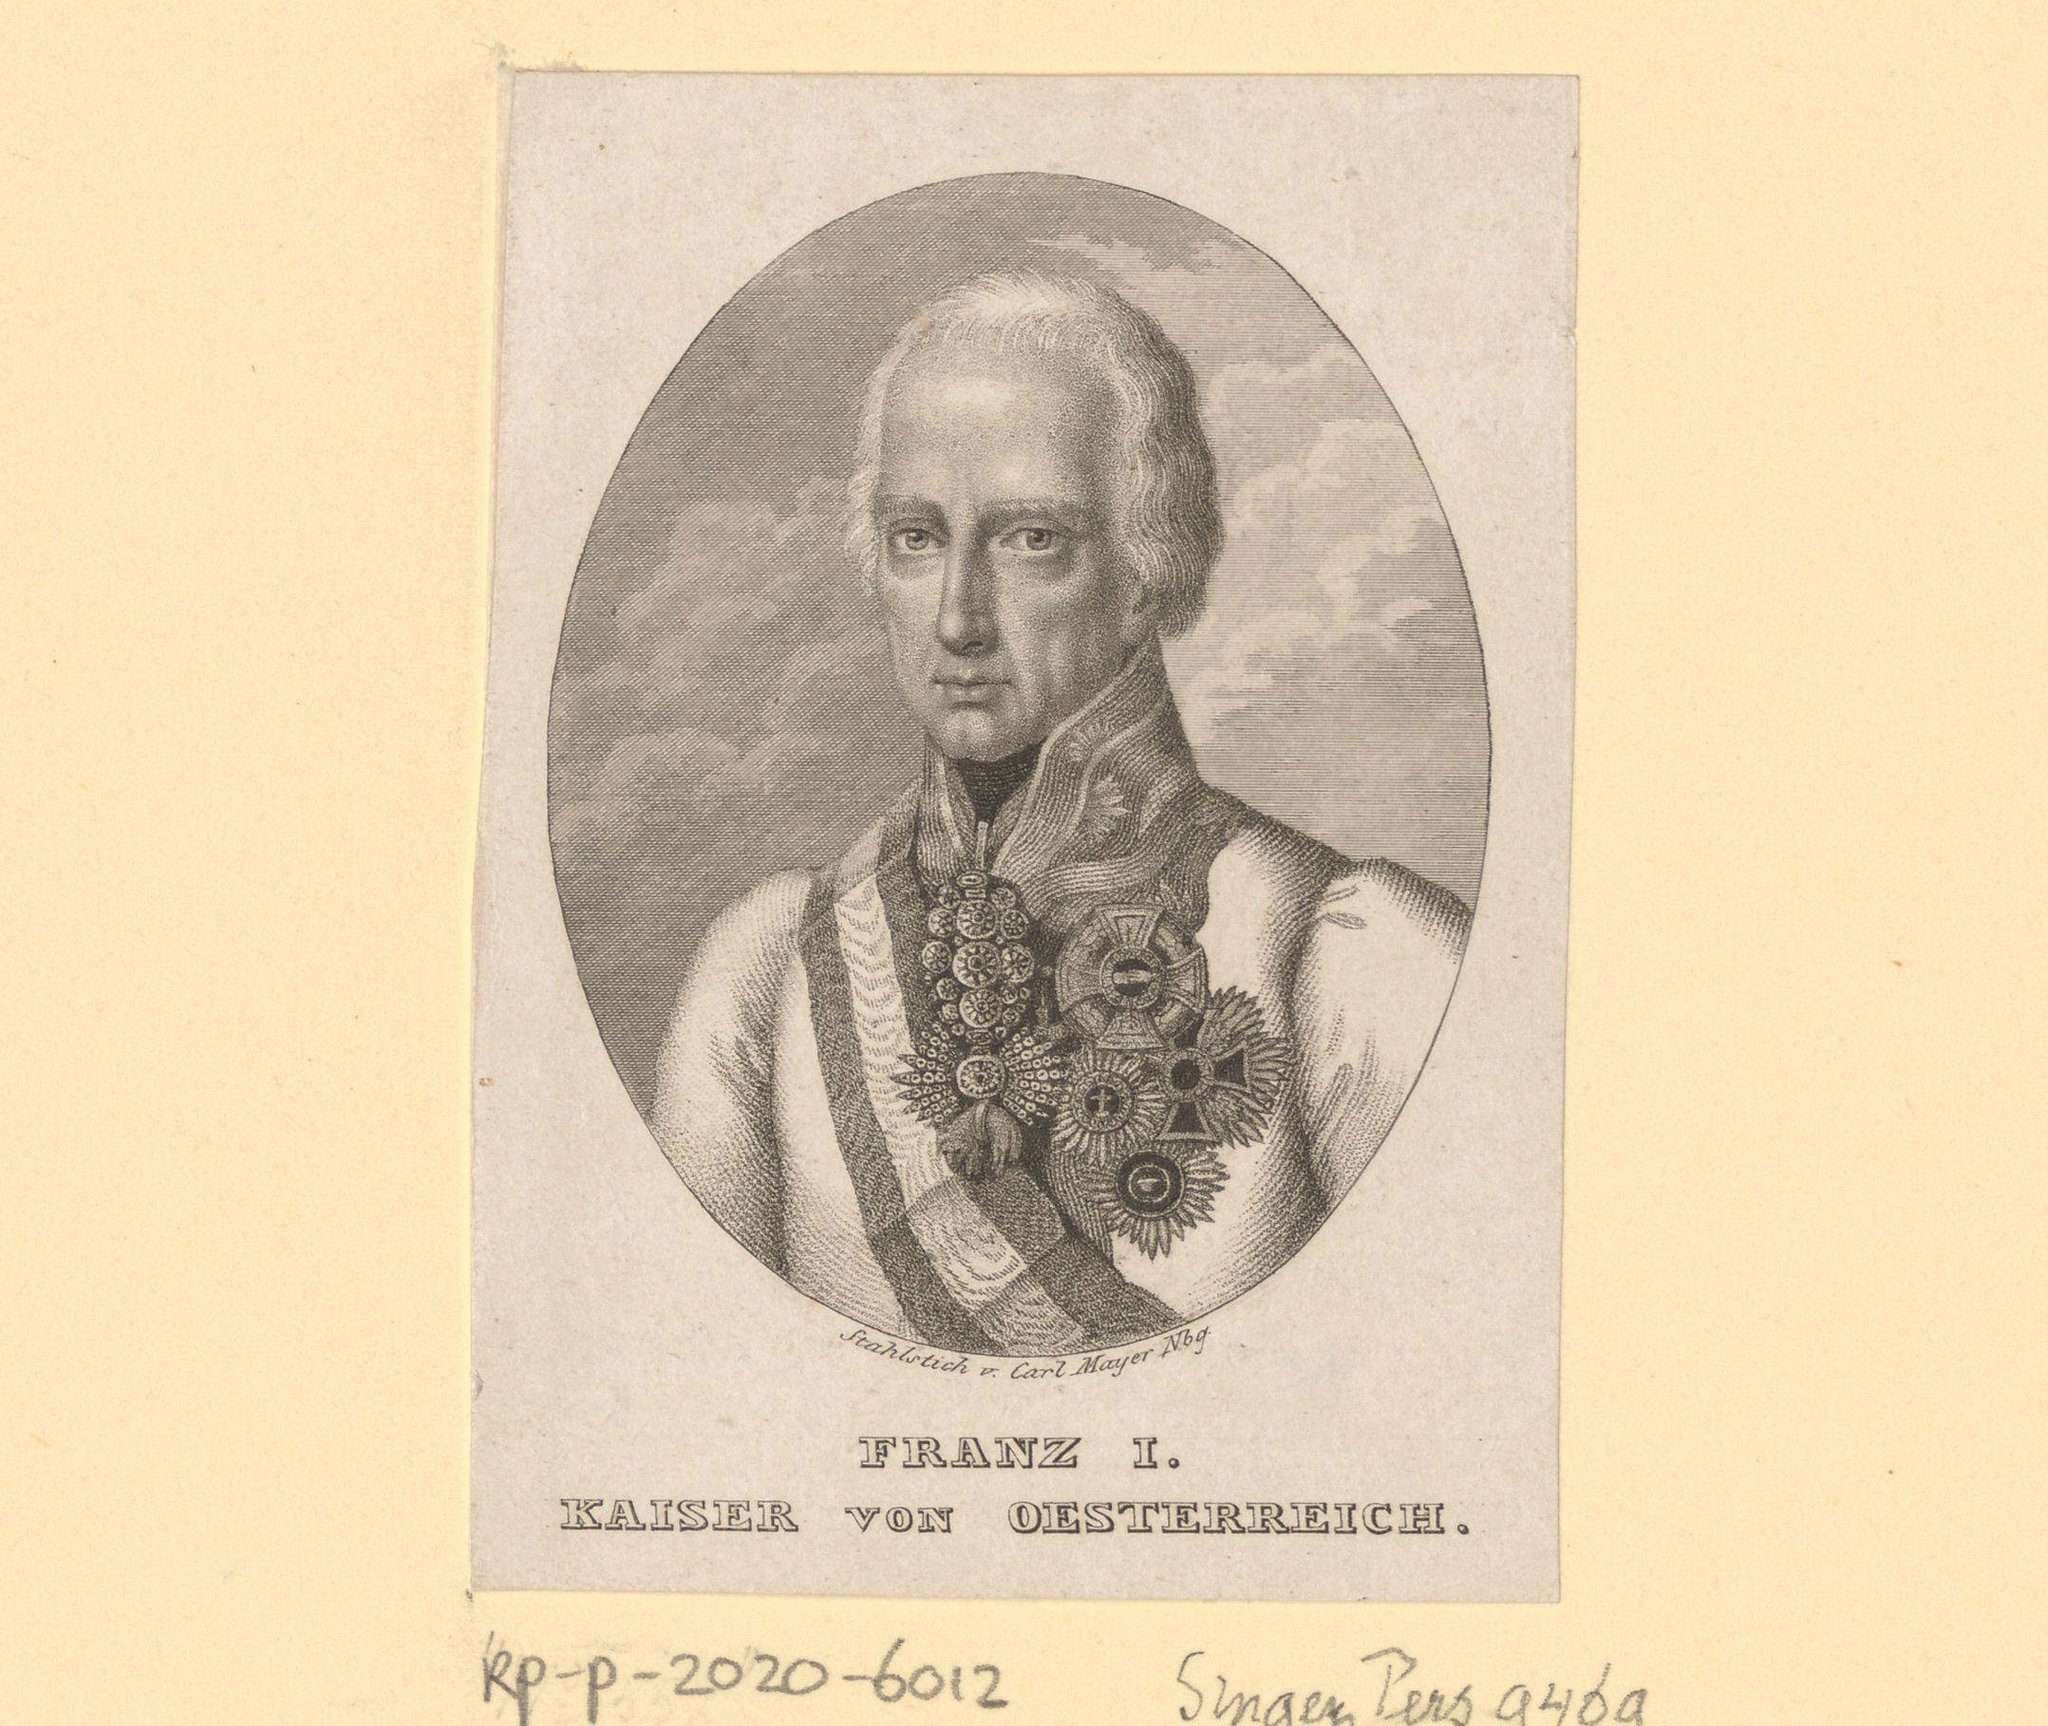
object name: print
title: Portret van Frans I, keizer van Oostenrijk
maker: carl mayer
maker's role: print maker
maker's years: 1798-1868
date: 1820-1834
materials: paper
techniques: engraving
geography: nuremberg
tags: vienna, frans ii (rooms-duits keizer), historical persons, emperor